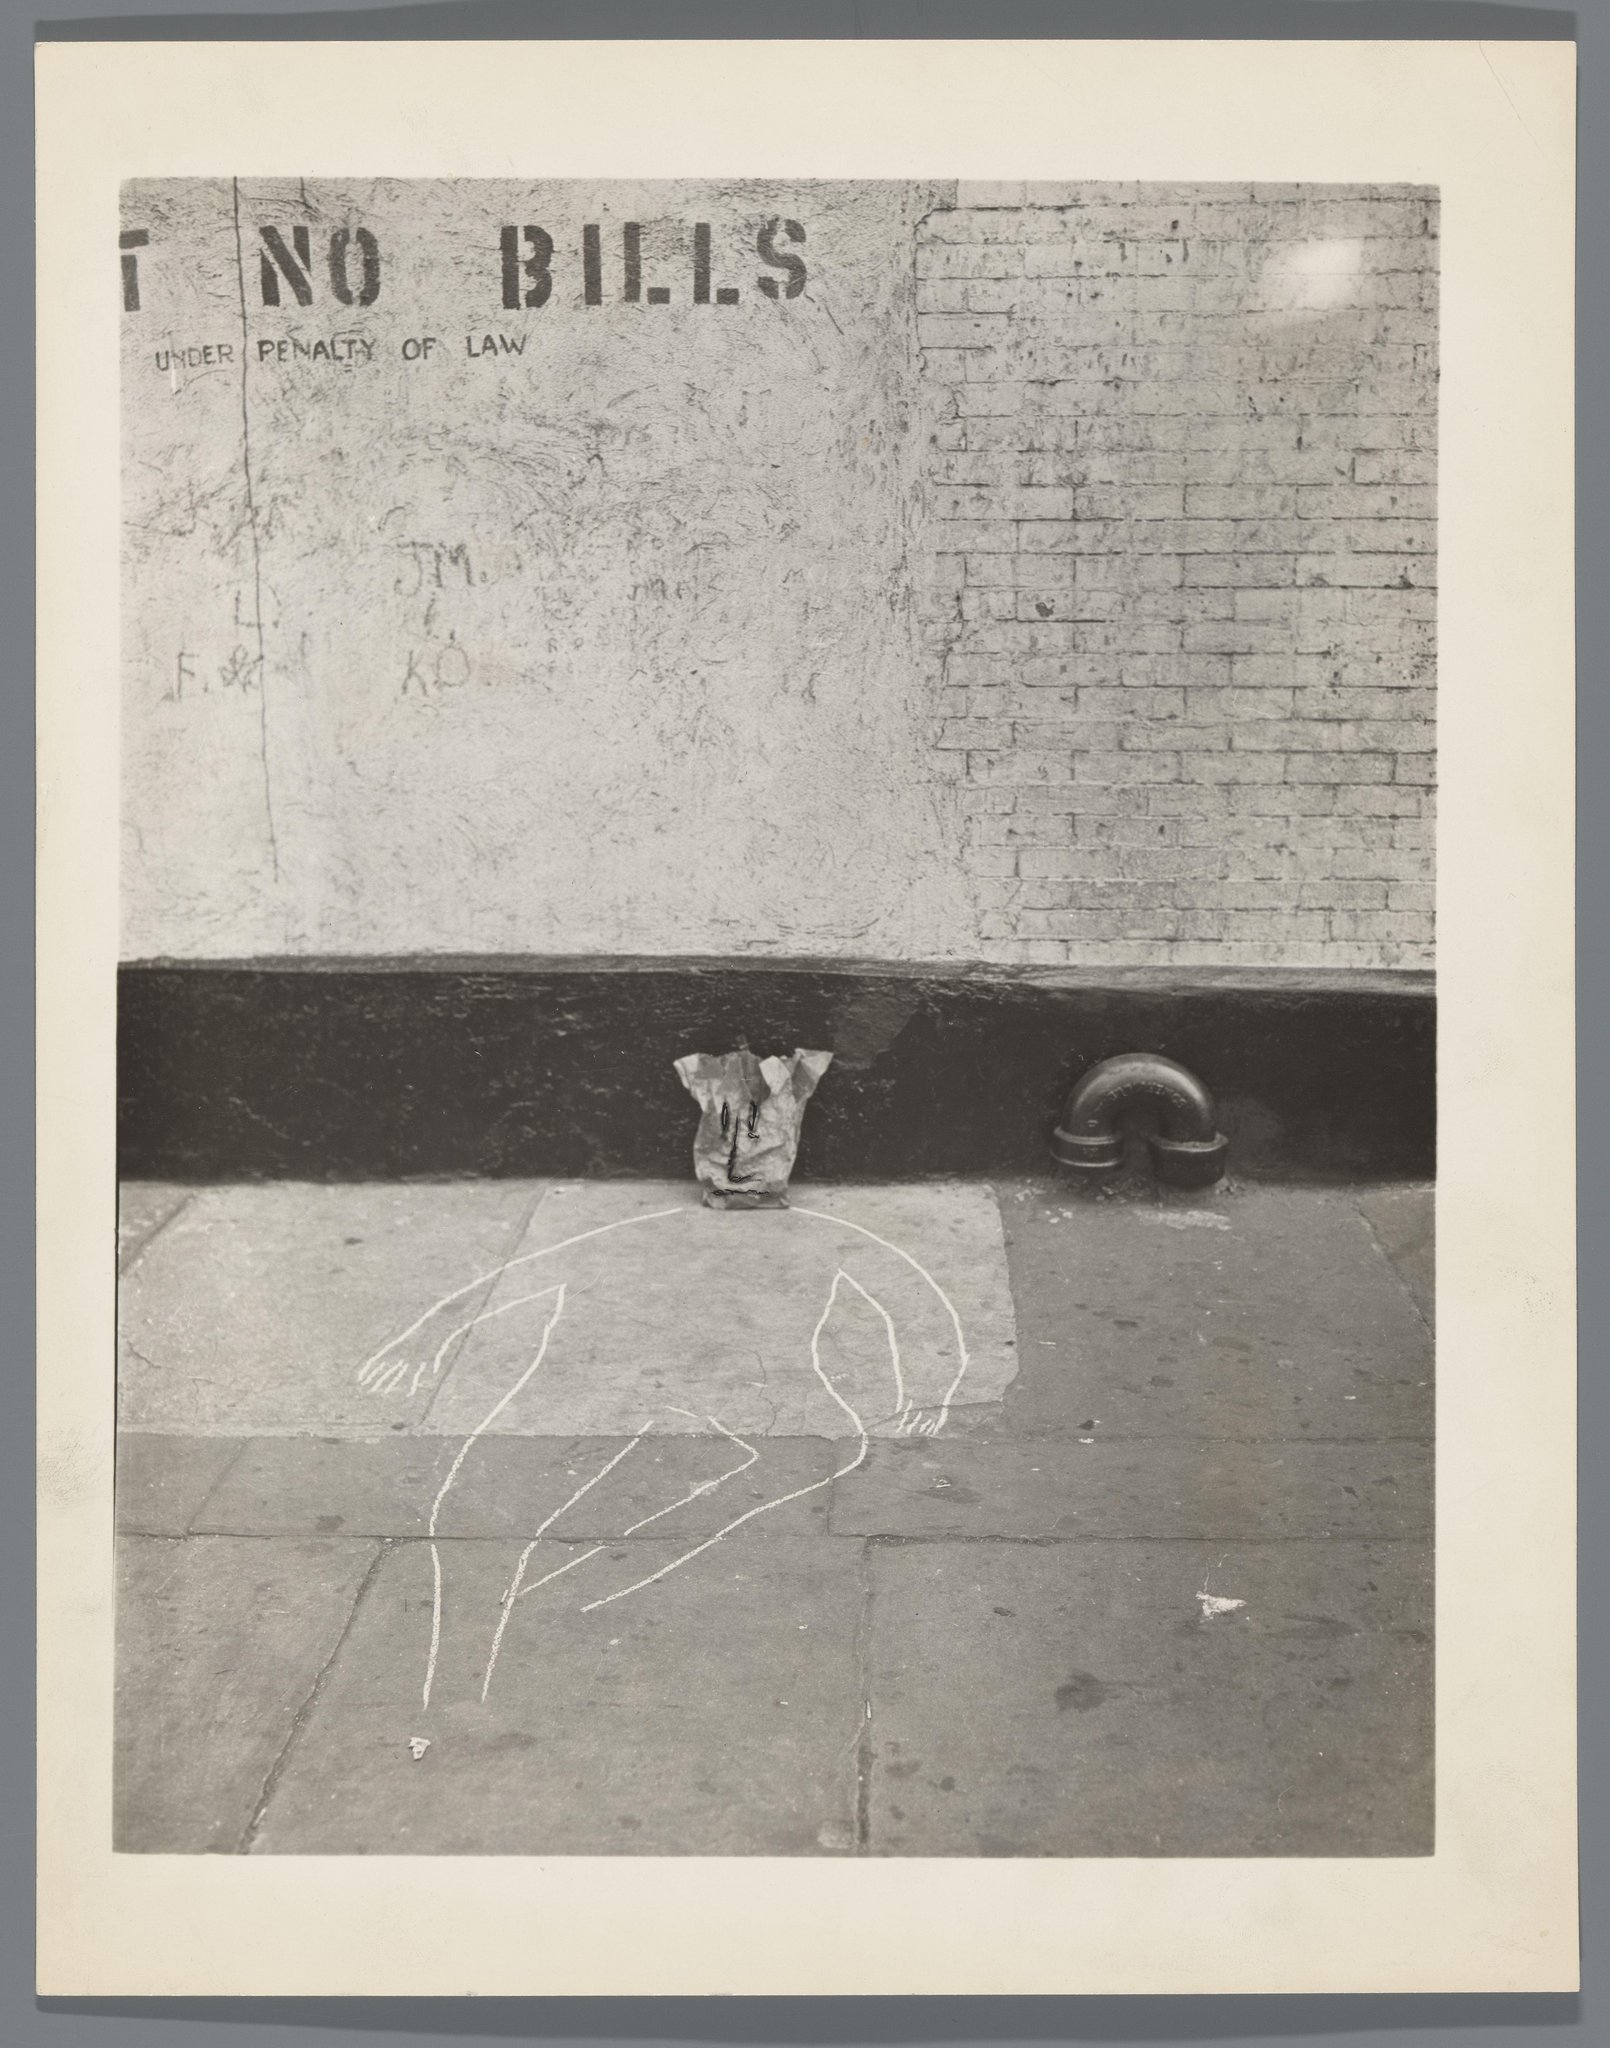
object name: photograph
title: Man op straat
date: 1950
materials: paper, photographic support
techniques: gelatin silver print, pen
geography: united states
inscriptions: stamp: ‘4 2 2 JUN 13 1950 / BISSINGER’, inscription: ‘Steinberg Book - Sept’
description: Bruine papieren zak, waar met wit krijt de contouren van een mensenlichaam bij zijn getekend op het trottoir en vervolgens, op de afdruk, met pen een gezicht is getekend op de afbeelding van de papieren zak.